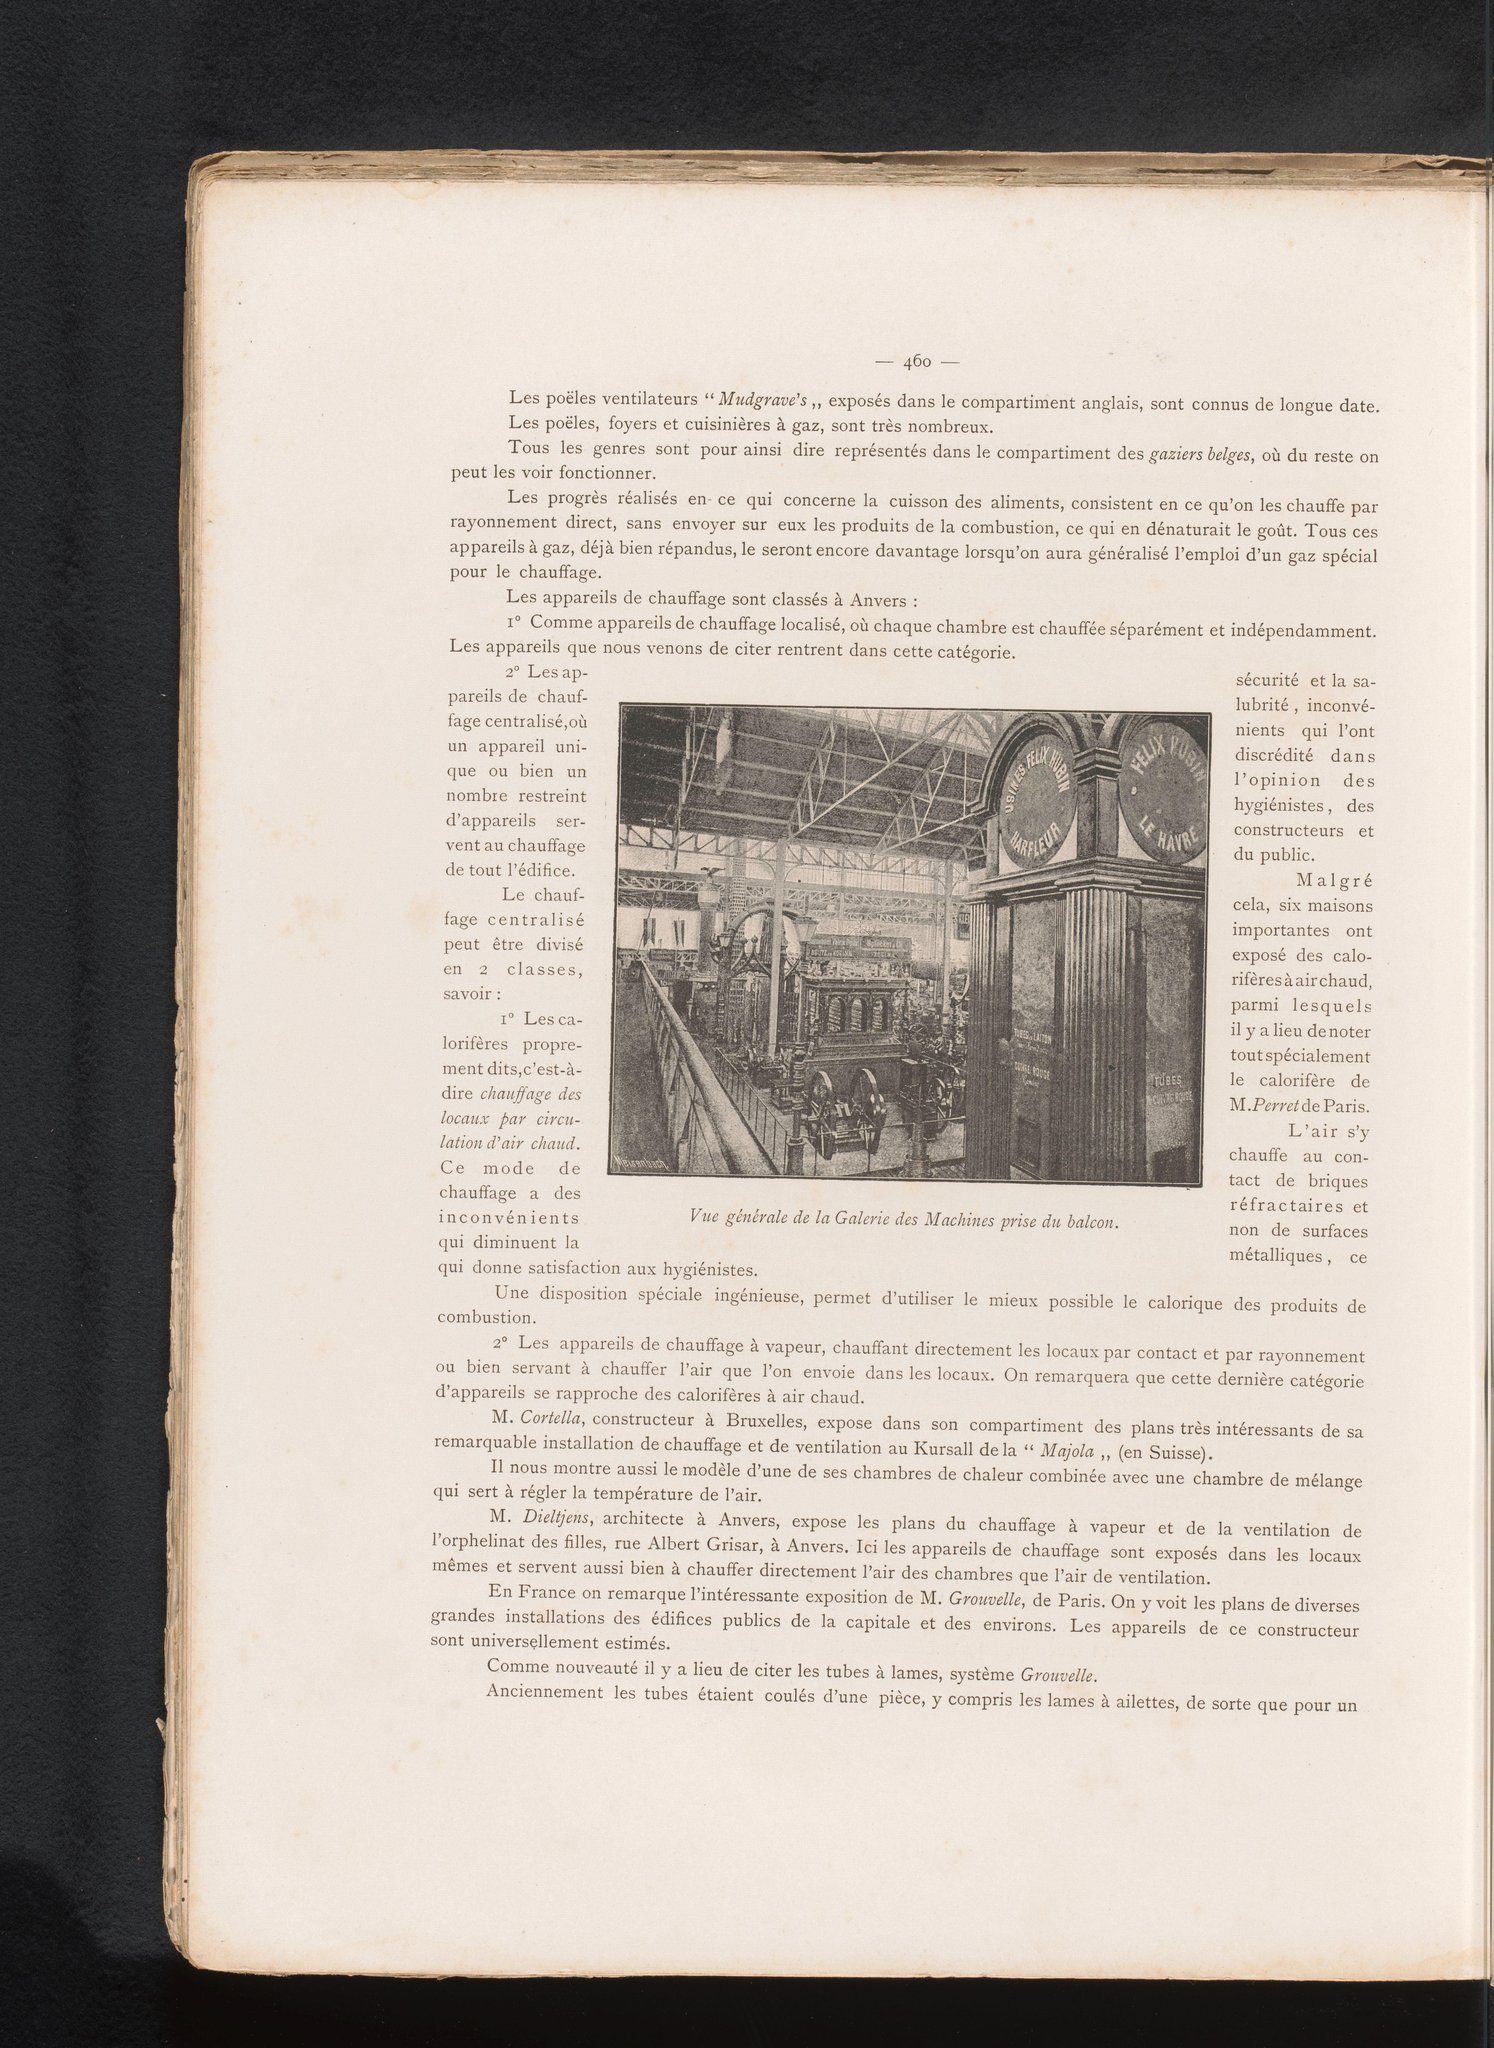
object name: page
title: Gezicht op de galerij met machines op de Wereldtentoonstelling van 1885 in Antwerpen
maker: Anonymous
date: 1880-1885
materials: paper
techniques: autotype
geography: antwerp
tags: world fair, world exhibition, antwerp